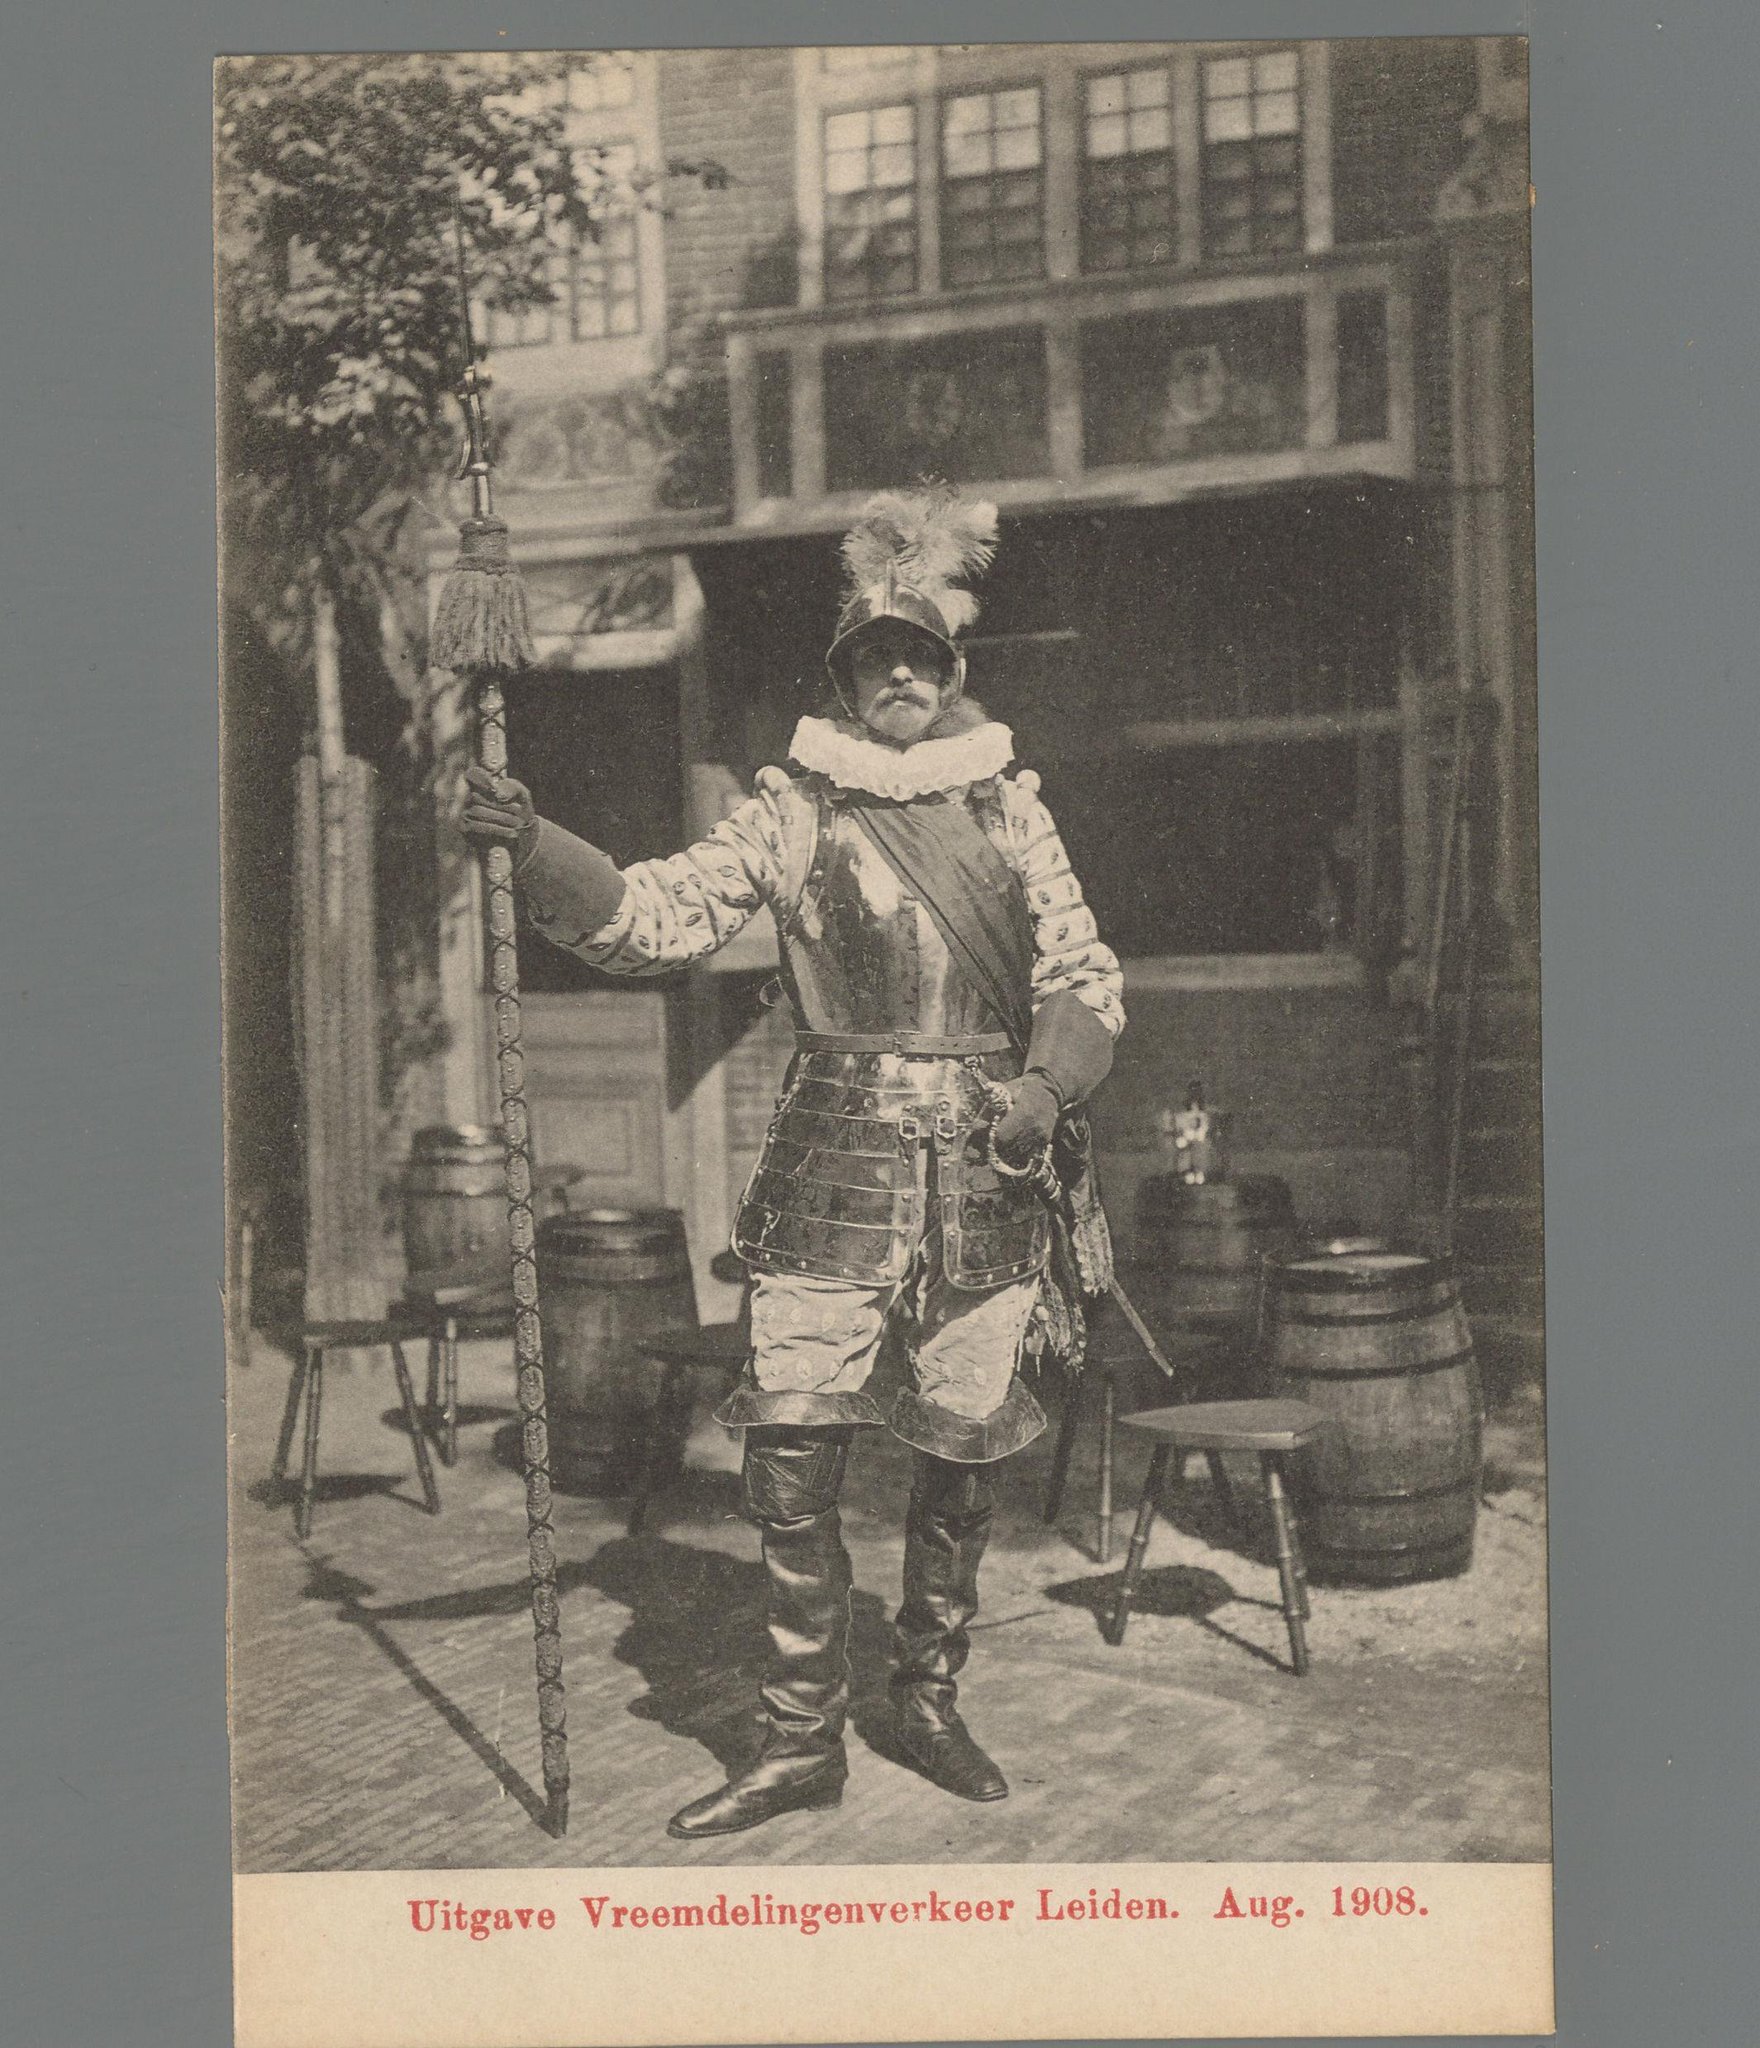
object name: ansichtkaart, prentbriefkaart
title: Man in kostuum tijdens de Oud-Hollandse feesten te Leiden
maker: Anonymous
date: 1908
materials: cardboard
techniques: photograph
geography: haarlem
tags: dress-up party, armour, casting weapons: spear, festivities, historical persons (portraits and scenes from the life), leiden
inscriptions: date